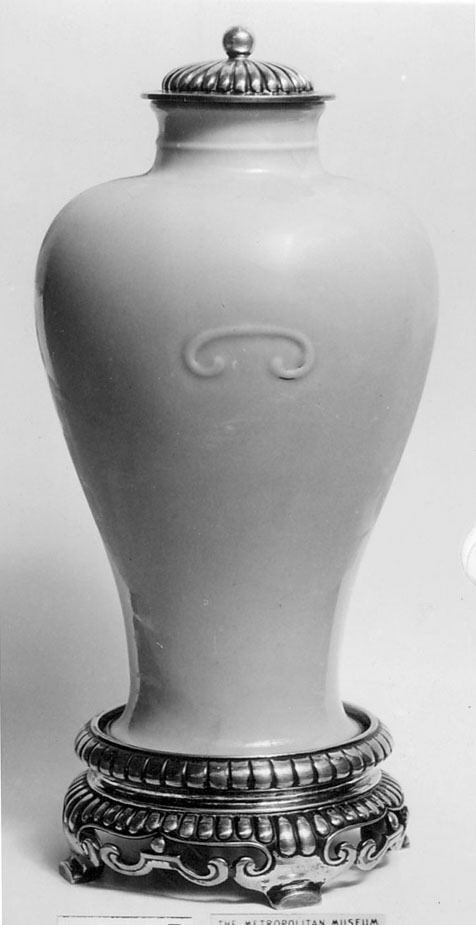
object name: vase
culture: chinese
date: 1701-1800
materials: glaze, porcelain